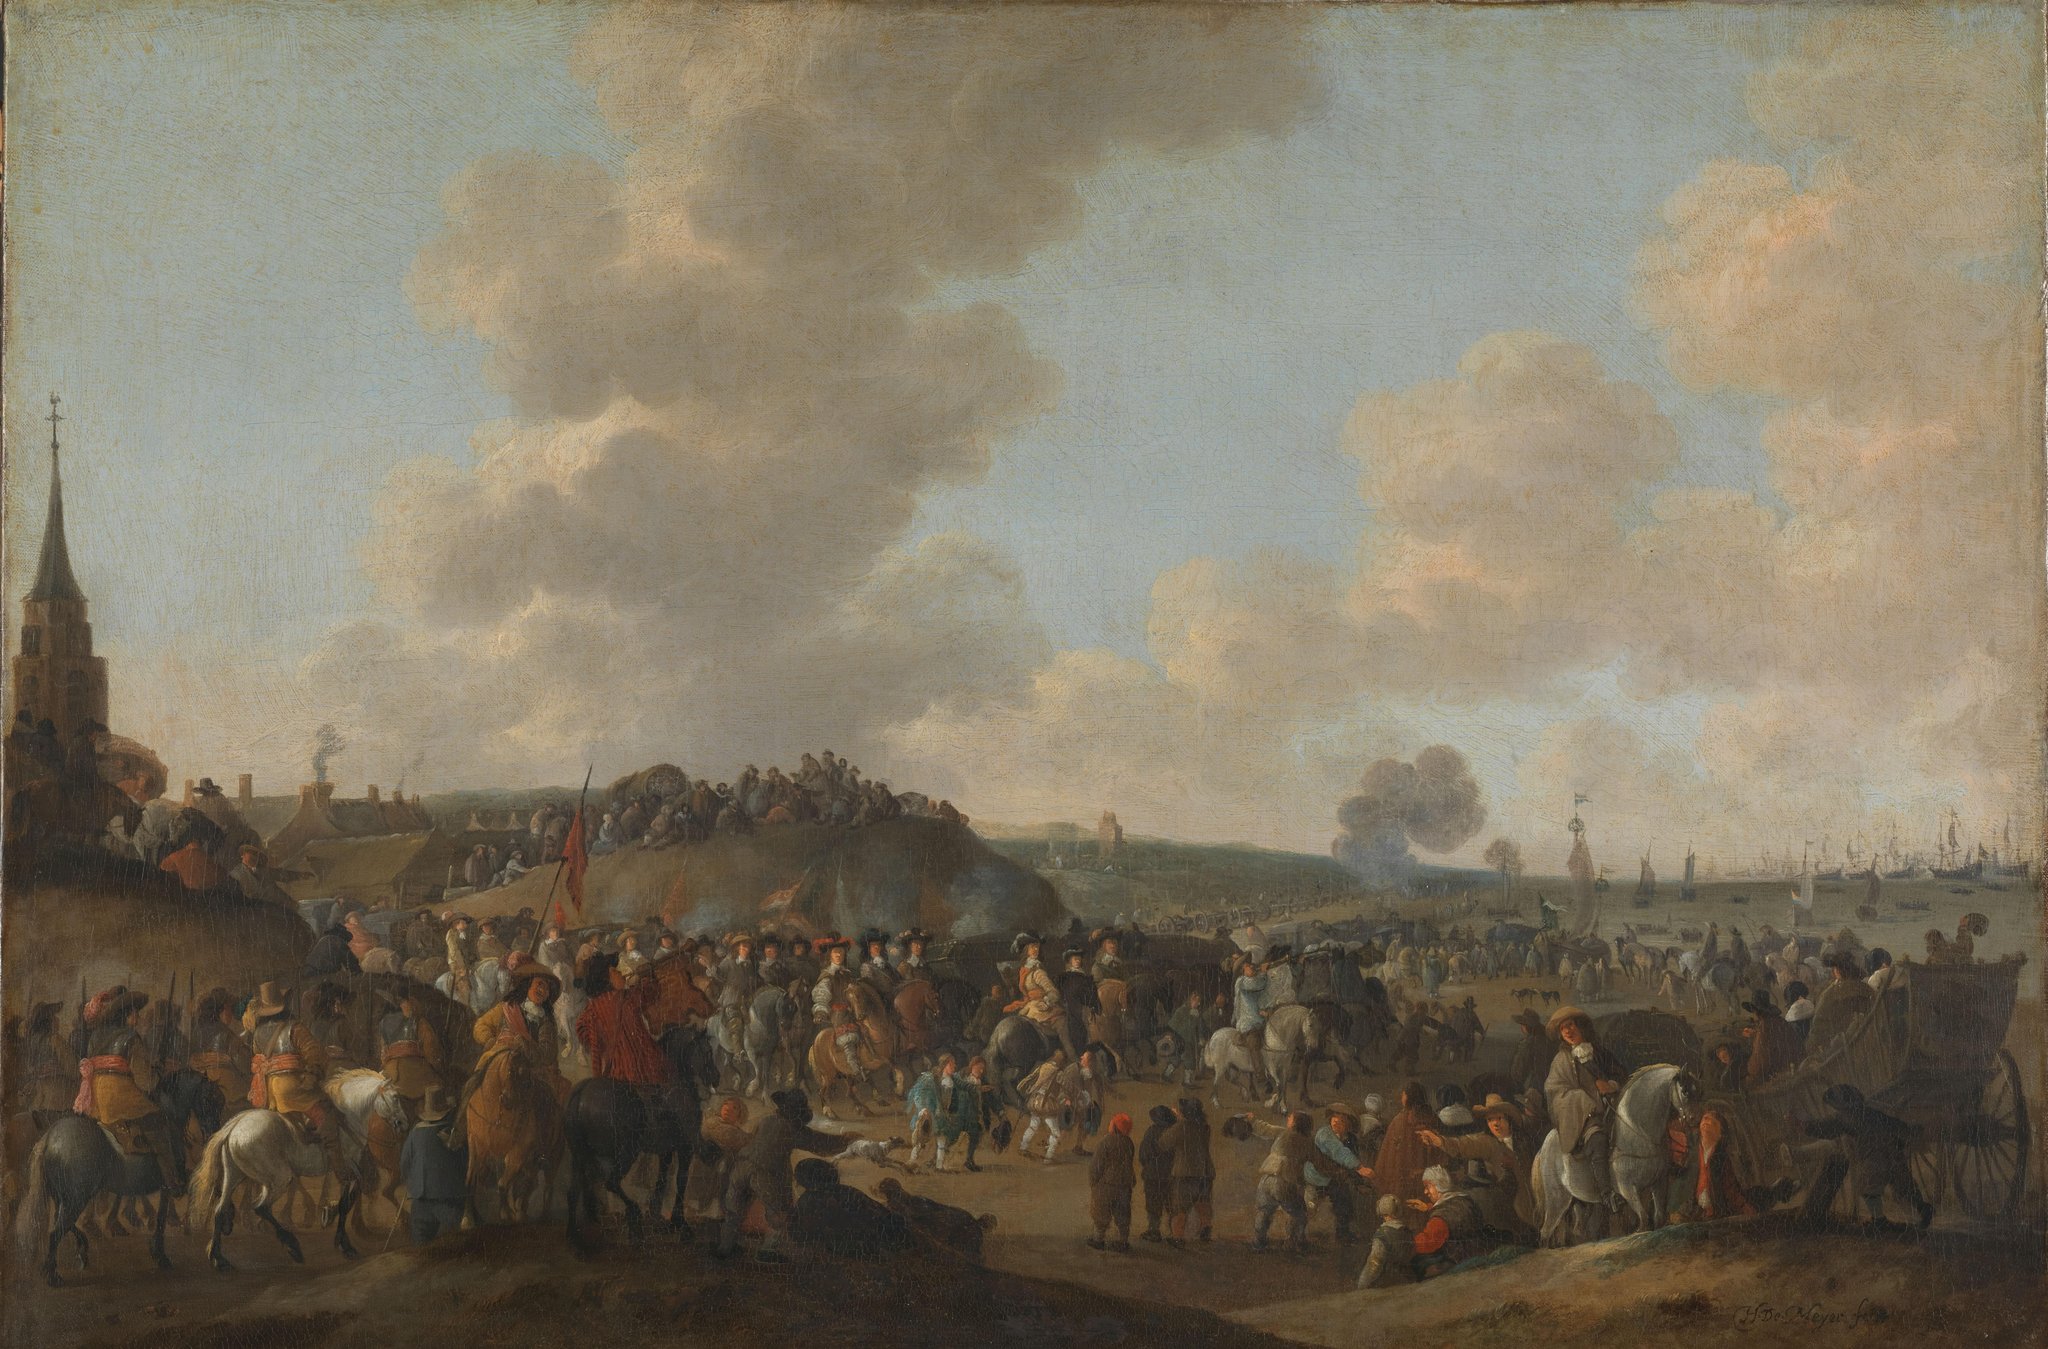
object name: painting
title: The Departure of Charles II of England from Scheveningen, June 2, 1660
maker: hendrick de meijer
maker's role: painter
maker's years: 1620-1698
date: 1660-1683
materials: canvas, oil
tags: london, karel ii (koning van engeland), crowd, mob, departure ~ travelling, beach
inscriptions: signature: ‘H. De Meyer fecit’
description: Het vertrek van Karel II, koning van Engeland, uit Scheveningen op 2 juni 1660. Op het strand heeft zich een grote mensenmassa verzameld. Links een stoet officieren te paard, voorafgegaan door herauten, op de achtergrond de gebouwen en de kerk van het dorp Scheveningen. Rechts een wagen met passagiers. Op het strand staat een rij kanonnen.